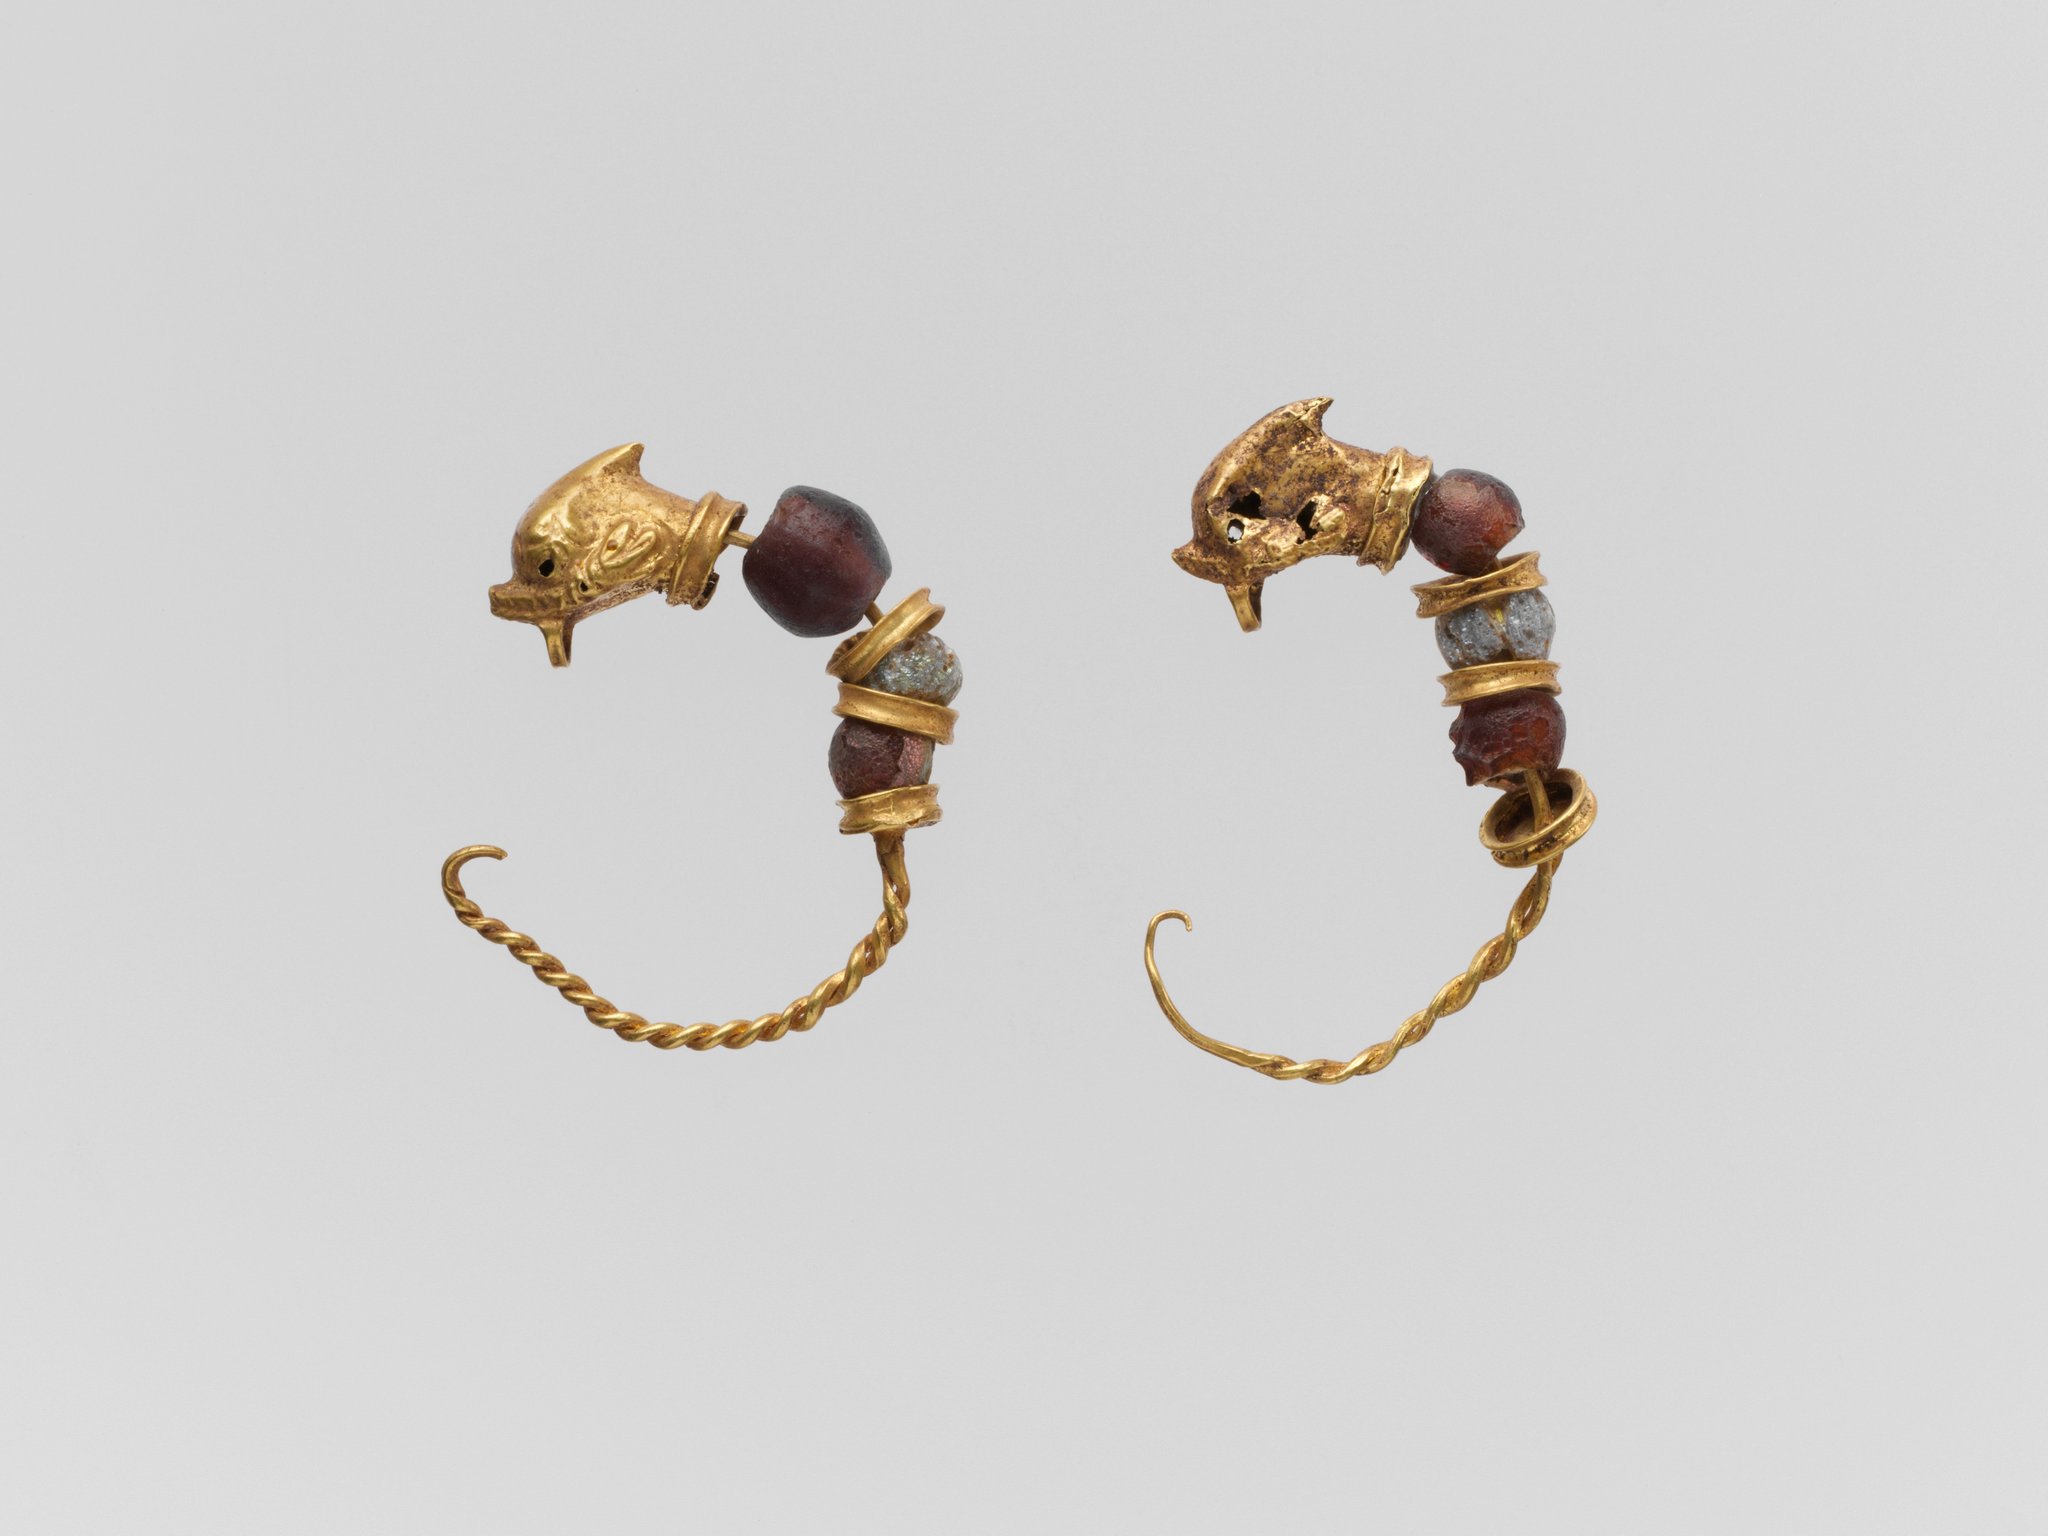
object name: earring with head of dolphin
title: Gold and glass earring with head of a dolphin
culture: greek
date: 200-1 BCE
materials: glass, gold, paste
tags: dolphins